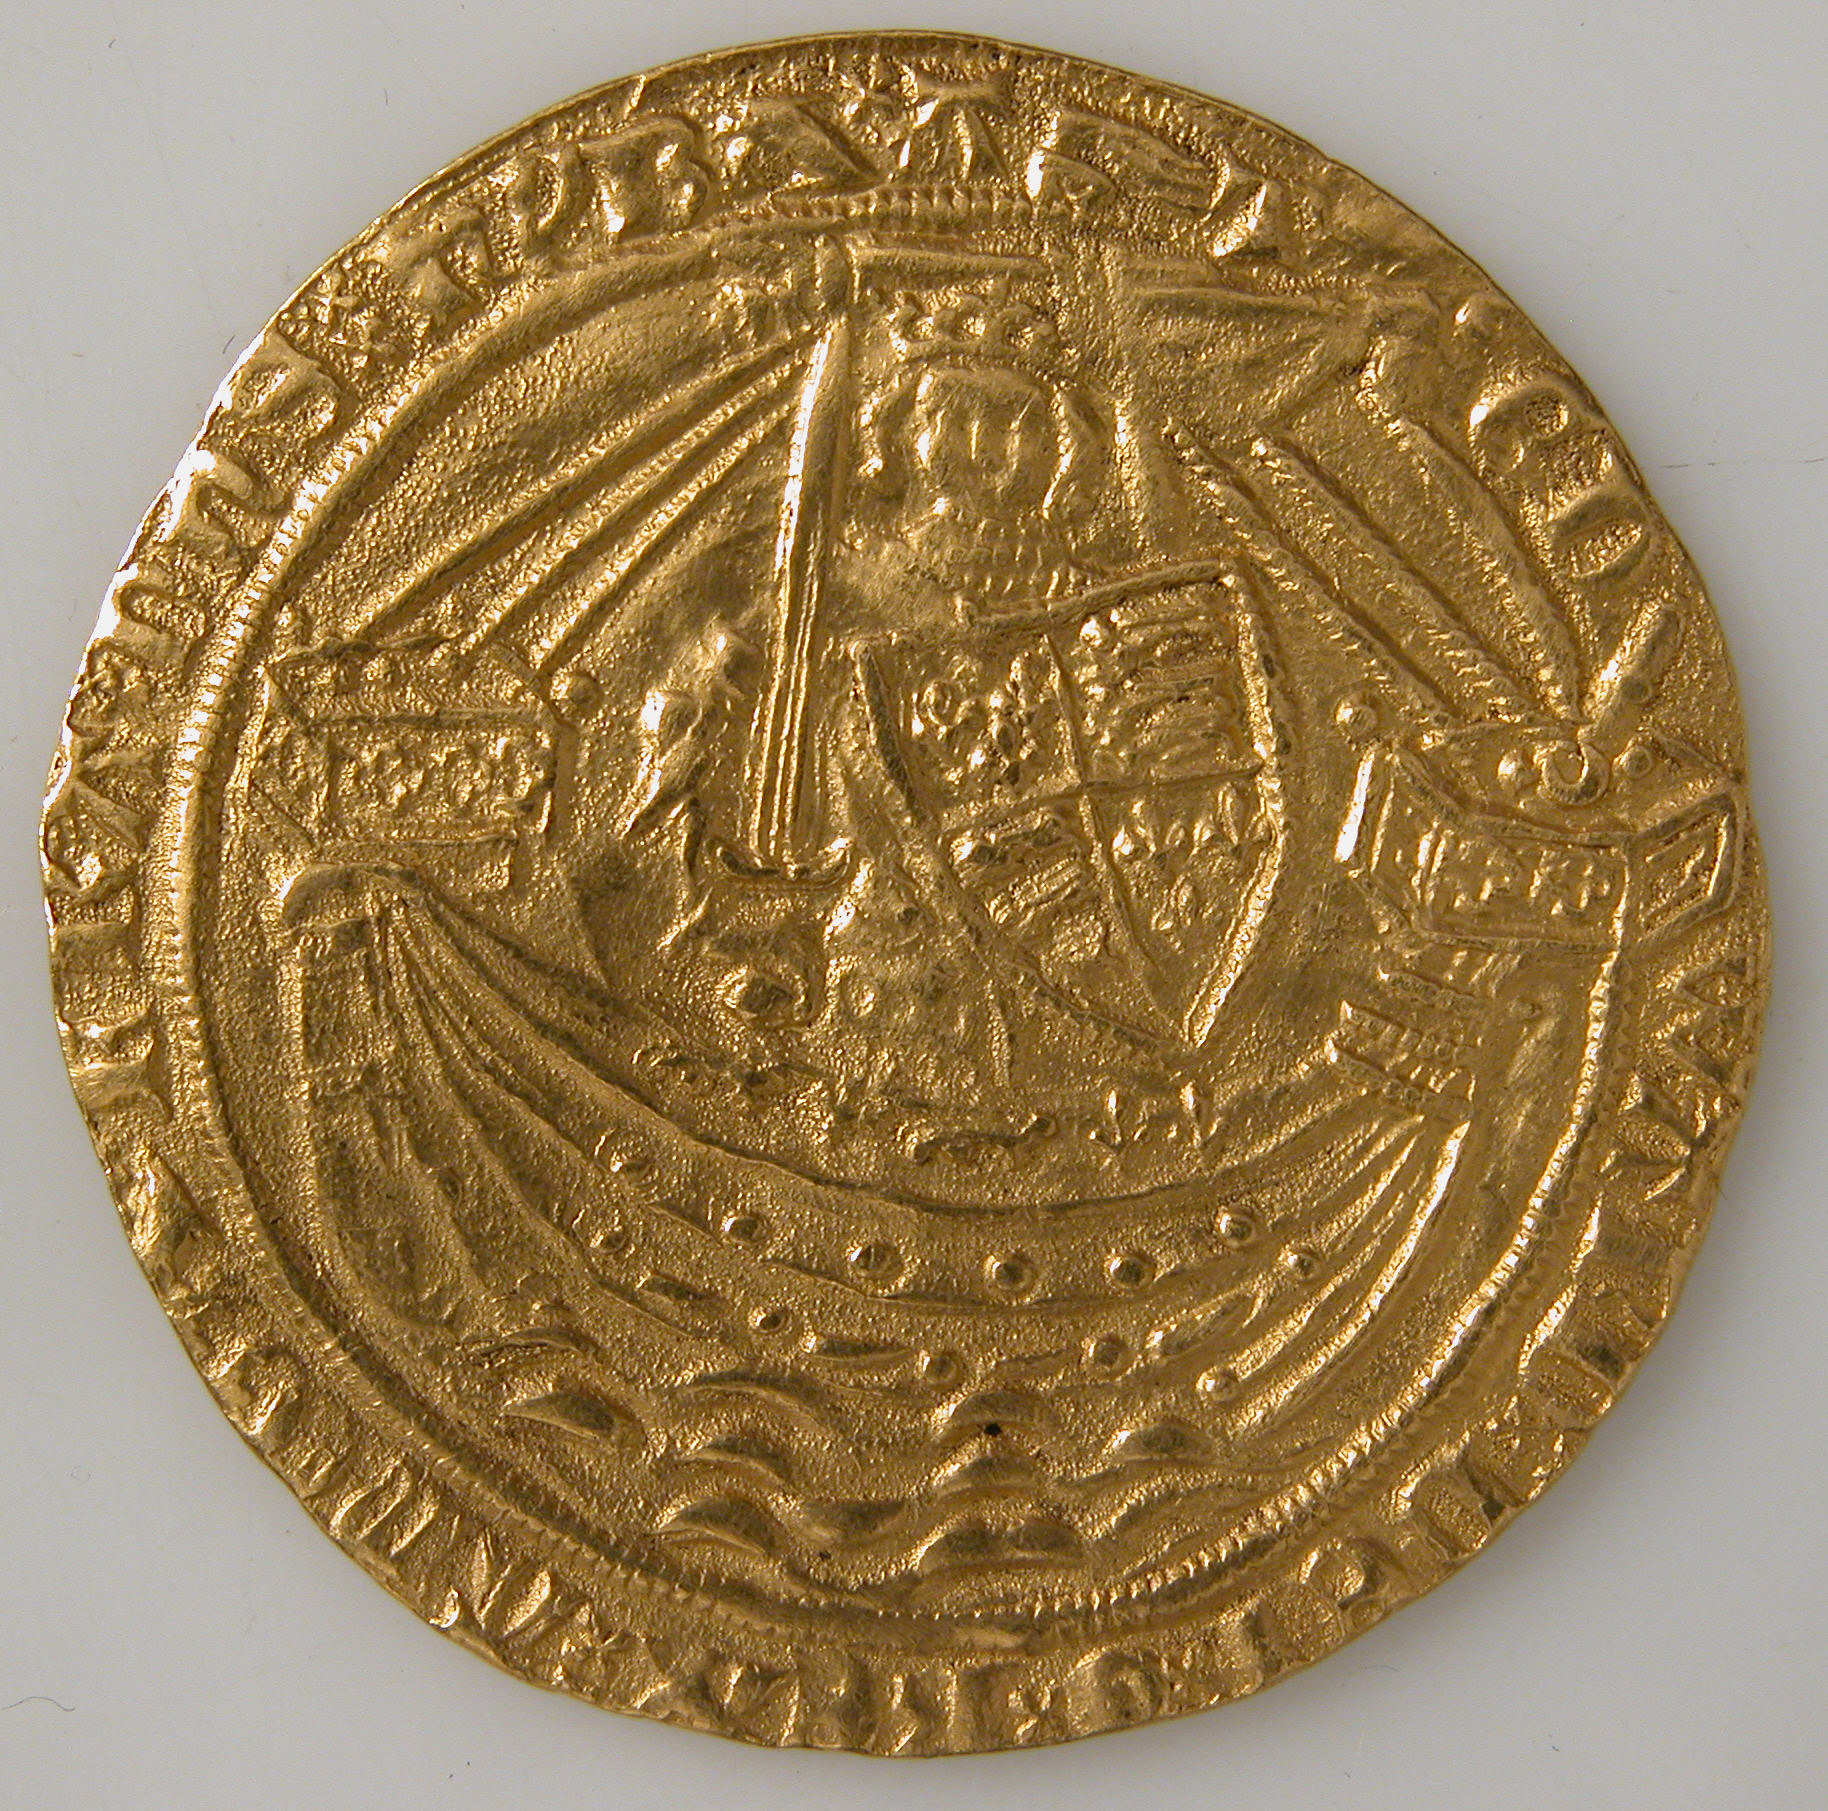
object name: coin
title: Noble of Edward III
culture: british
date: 1350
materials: gold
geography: england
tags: kings,coins,coat of arms